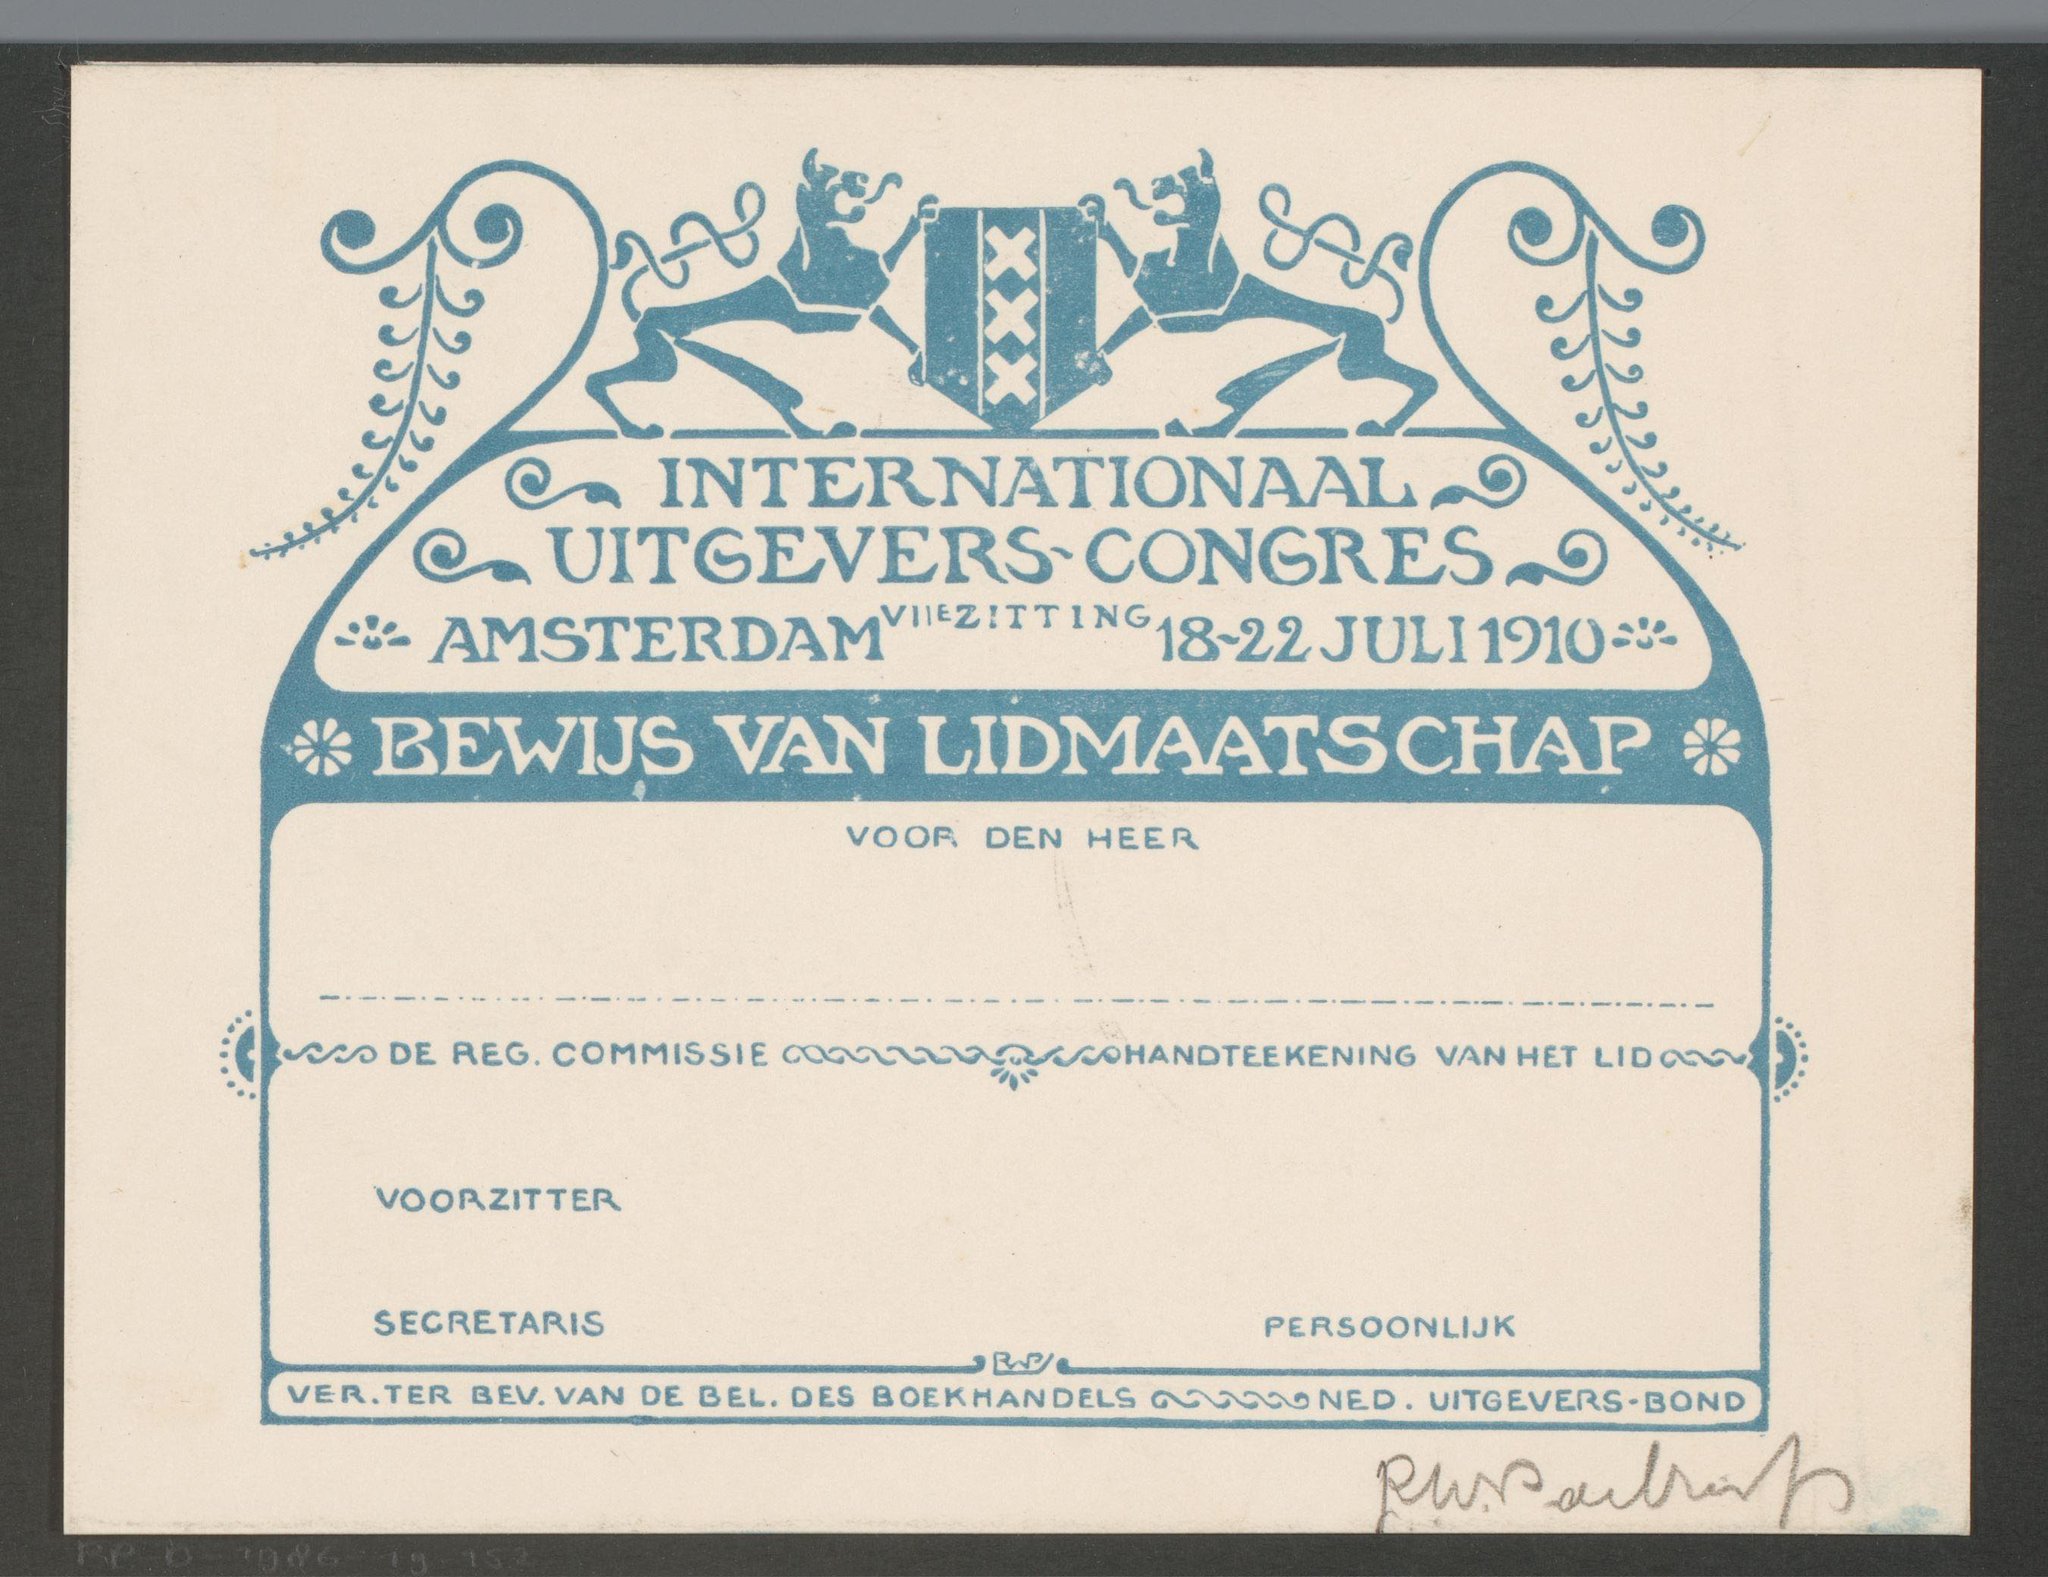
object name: photomechanical print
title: Lidmaatschapsbewijs voor het Internationaal Uitgevers-congres in 1910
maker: reinier willem petrus de vries (1874-1953)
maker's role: draughtsman, print maker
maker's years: 1874-1953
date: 1910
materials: paper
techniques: printing block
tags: coat of arms (as symbol of the state, etc.)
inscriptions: collector's mark: ‘R:MVS.’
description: Wapen van Amsterdam met aan weerszijden twee gestileerde honden met de tong uit de bek. Exemplaar van R.W.P. de Vries Jr., die zijn naam erop genoteerd heeft.